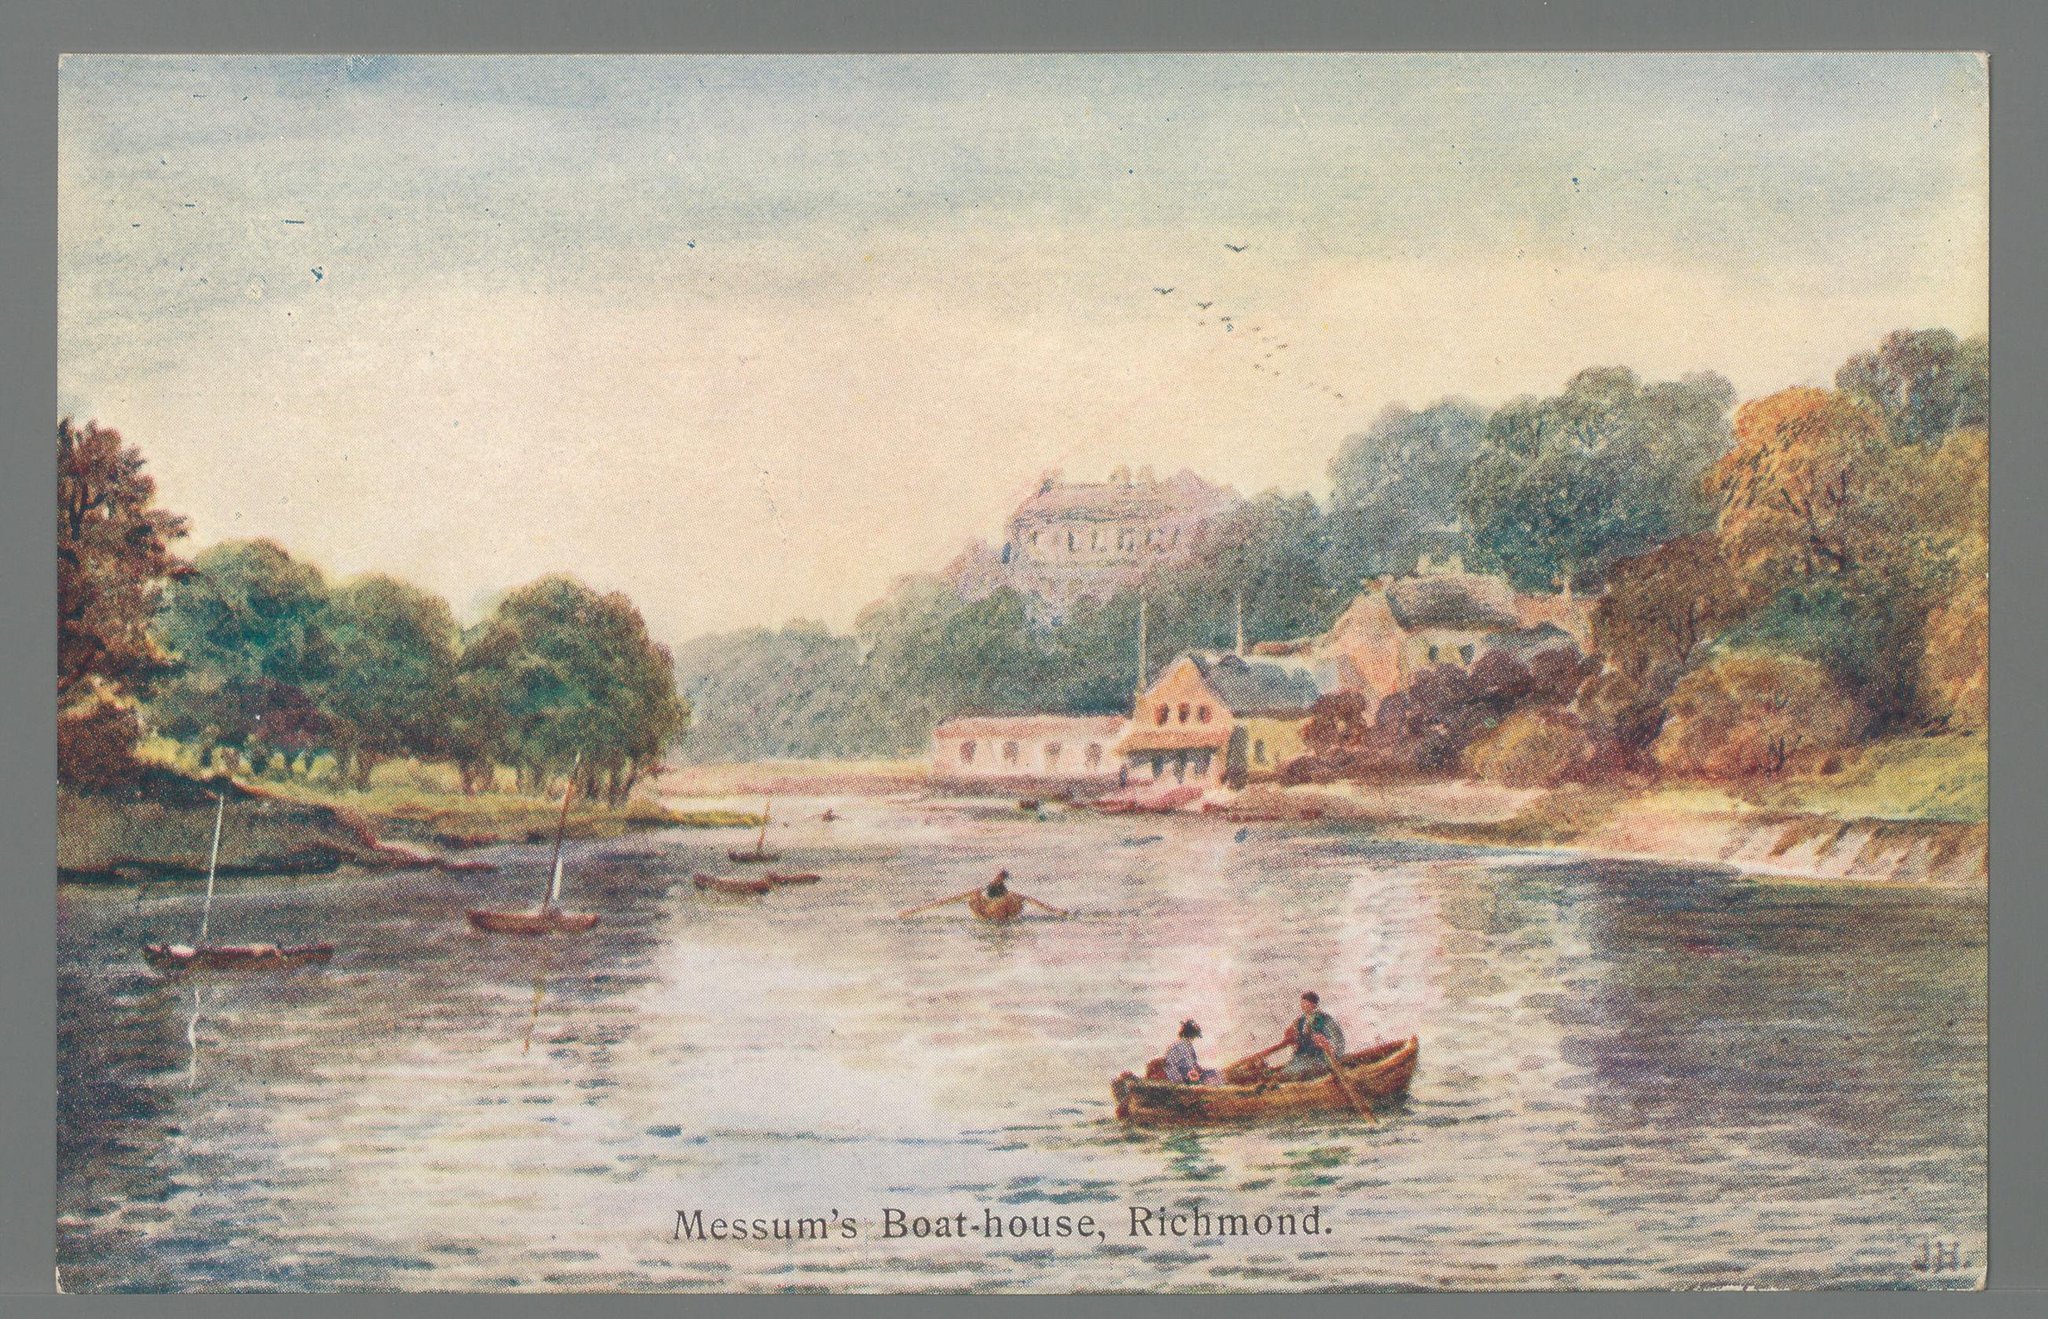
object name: reproduction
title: Messum's Boat-house, Richmond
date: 1902-1940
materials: cardboard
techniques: color autotype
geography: london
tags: rowing-boat, canoe, etc., canals, waters (in city), thames